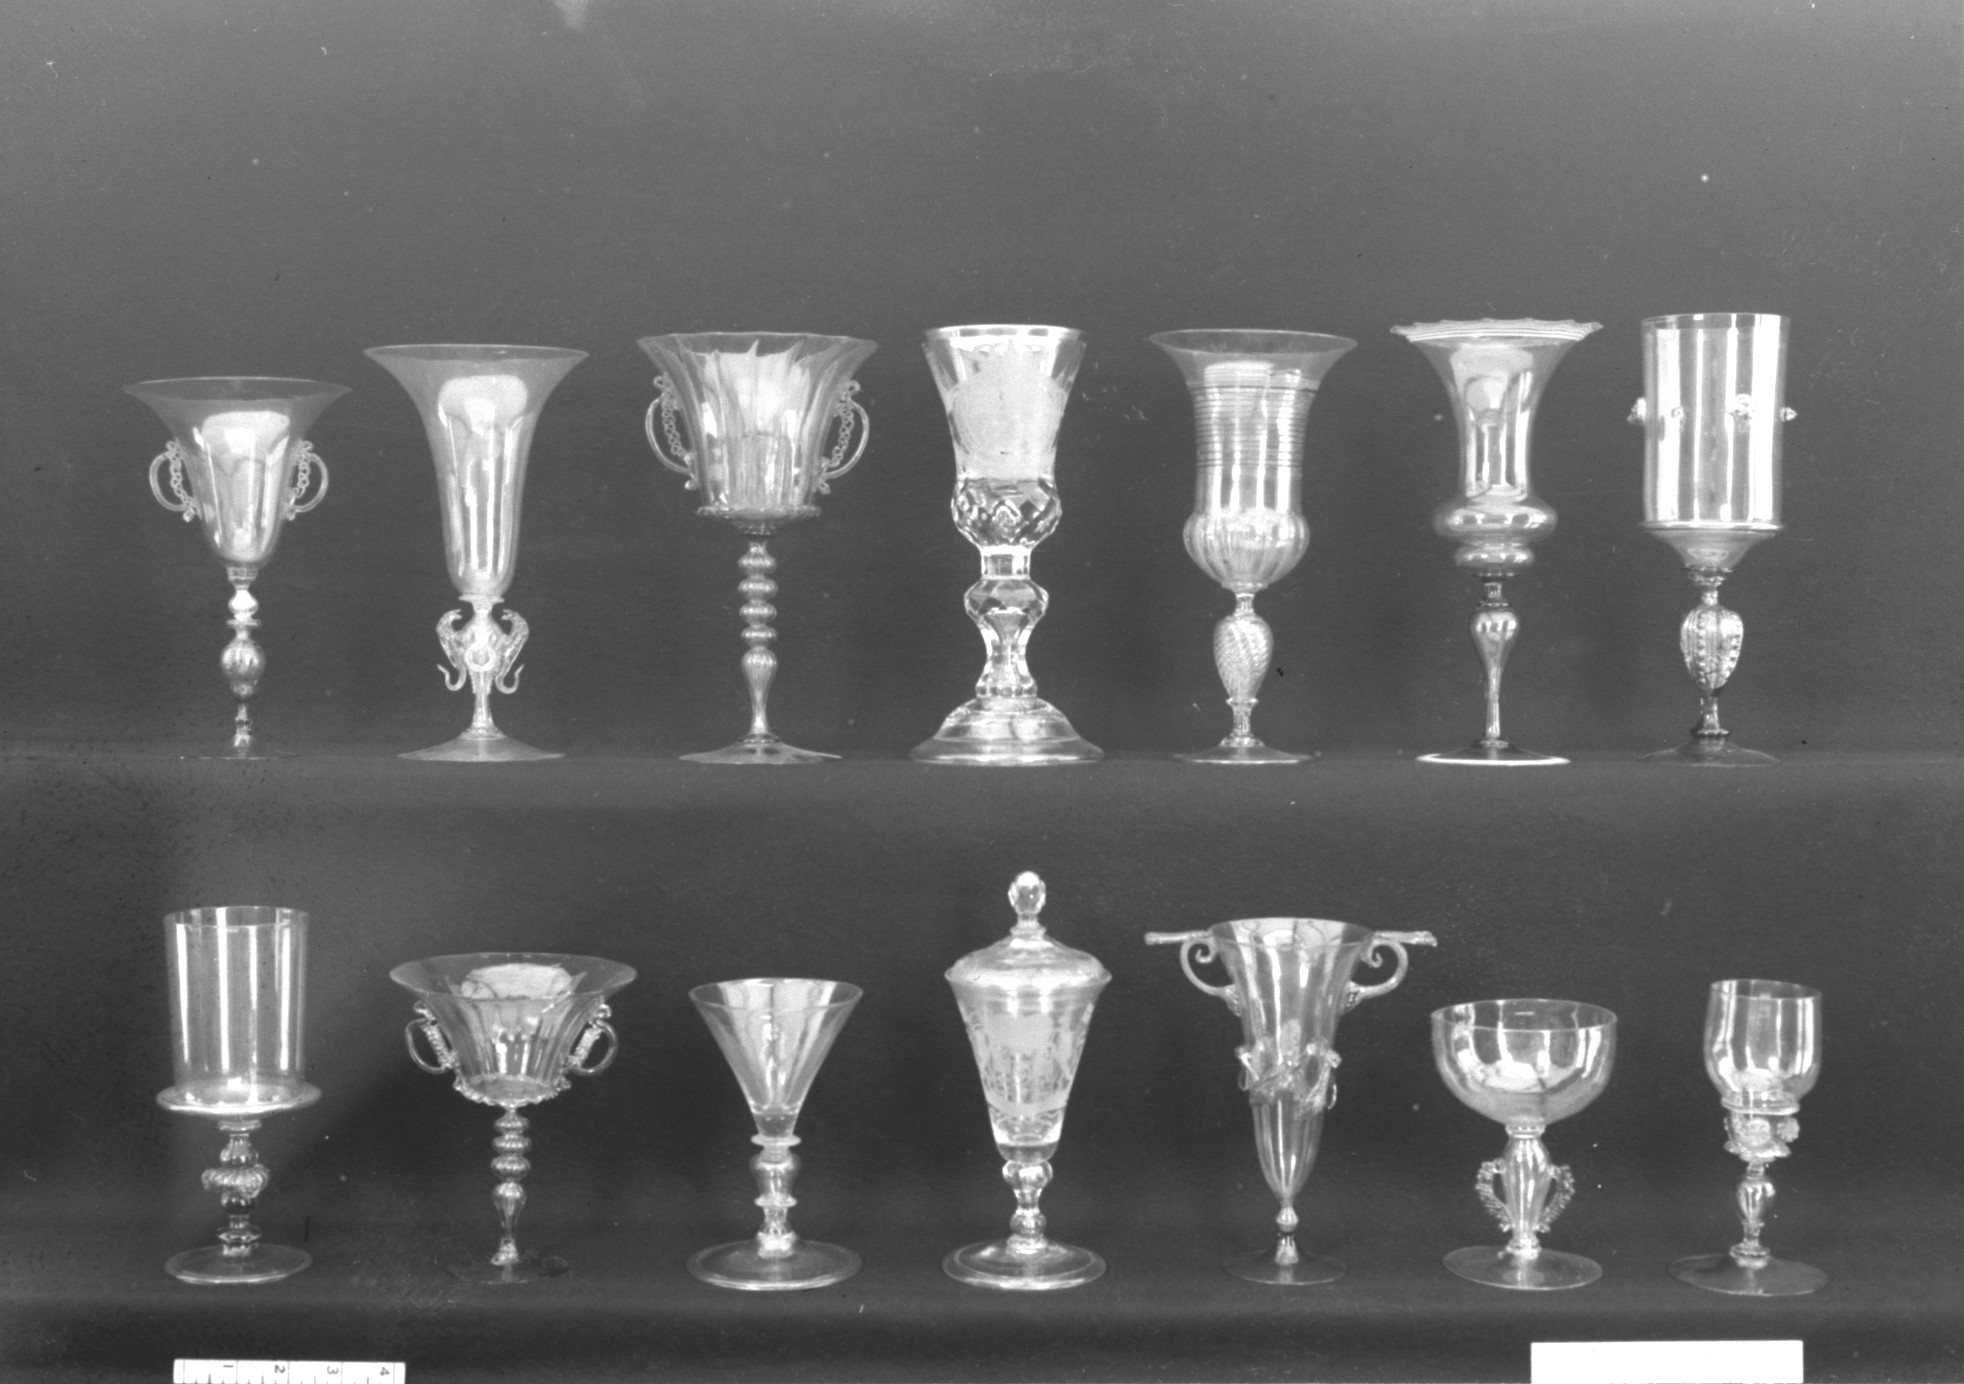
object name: wineglass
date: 1801-1900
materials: glass